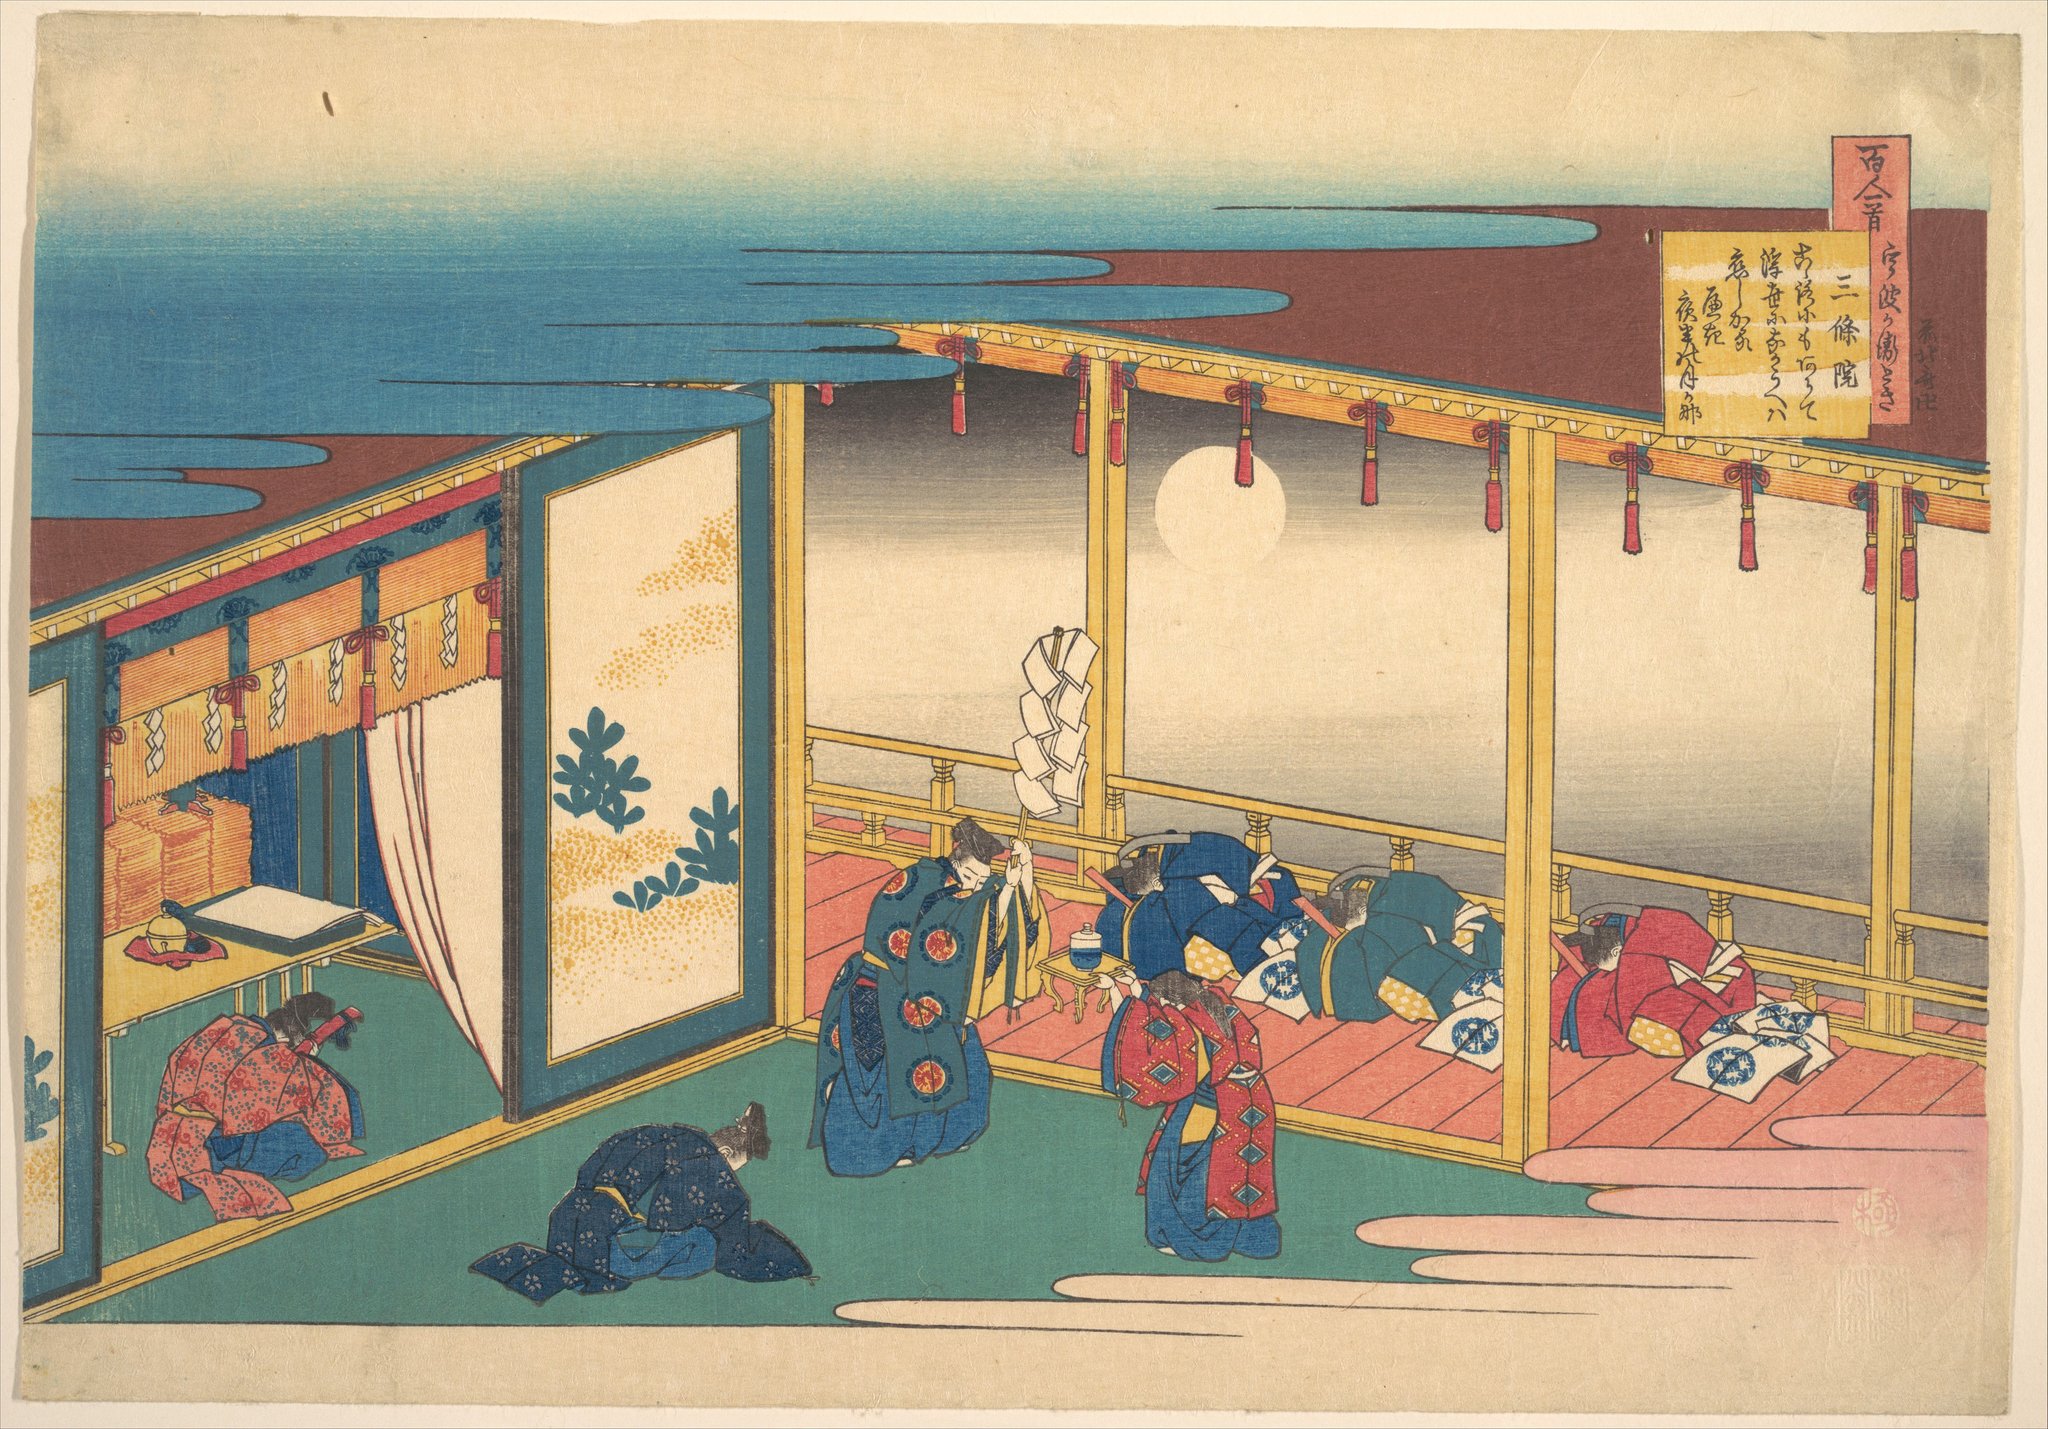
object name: woodblock print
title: Poem by Sanjō-in, from the series One Hundred Poems Explained by the Nurse (Hyakunin isshu uba ga etoki)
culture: japanese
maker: katsushika hokusai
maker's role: artist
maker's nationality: japanese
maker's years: 1760-1849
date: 1760-1849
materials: ink, paper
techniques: woodblock print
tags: human figures,poetry,moon